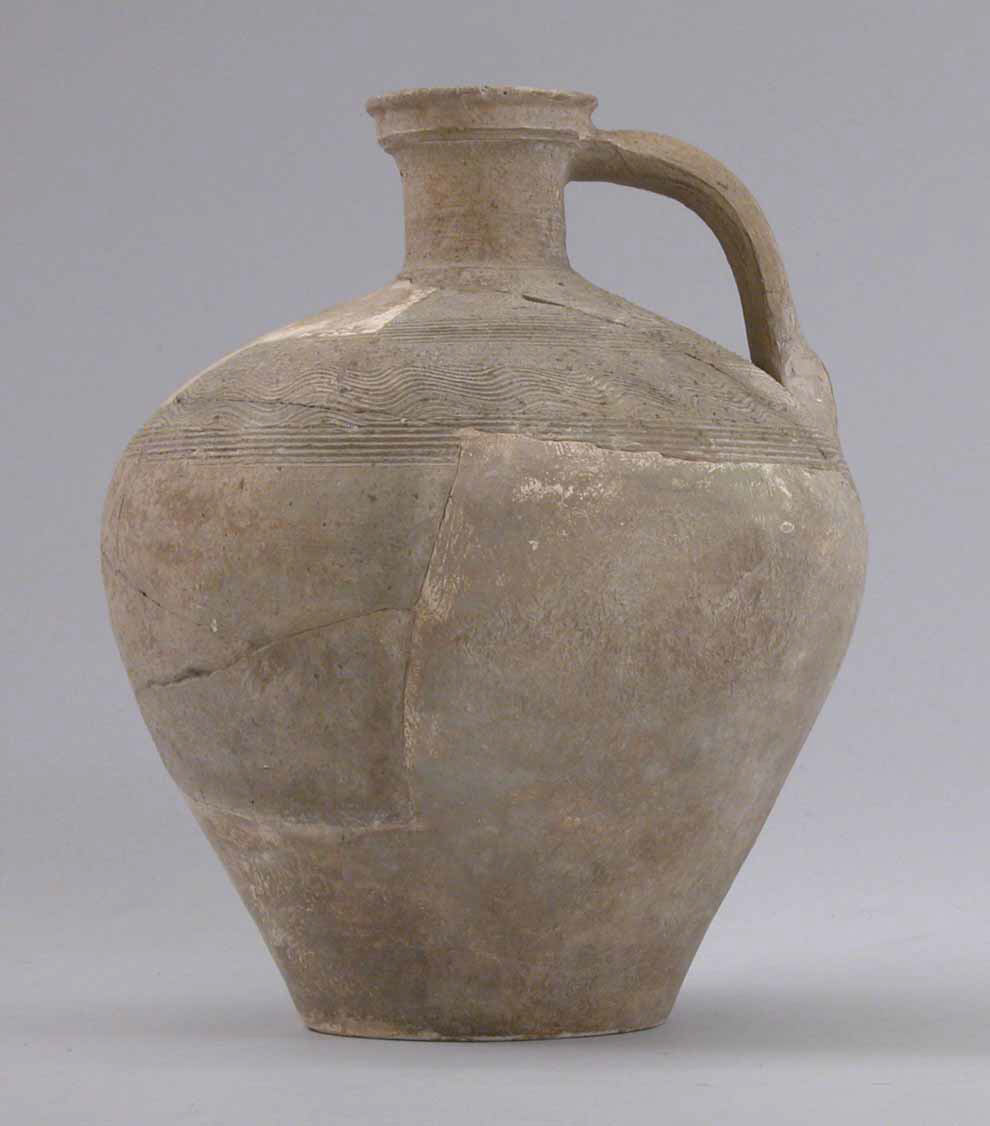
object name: ewer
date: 701-900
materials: earthenware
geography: iran